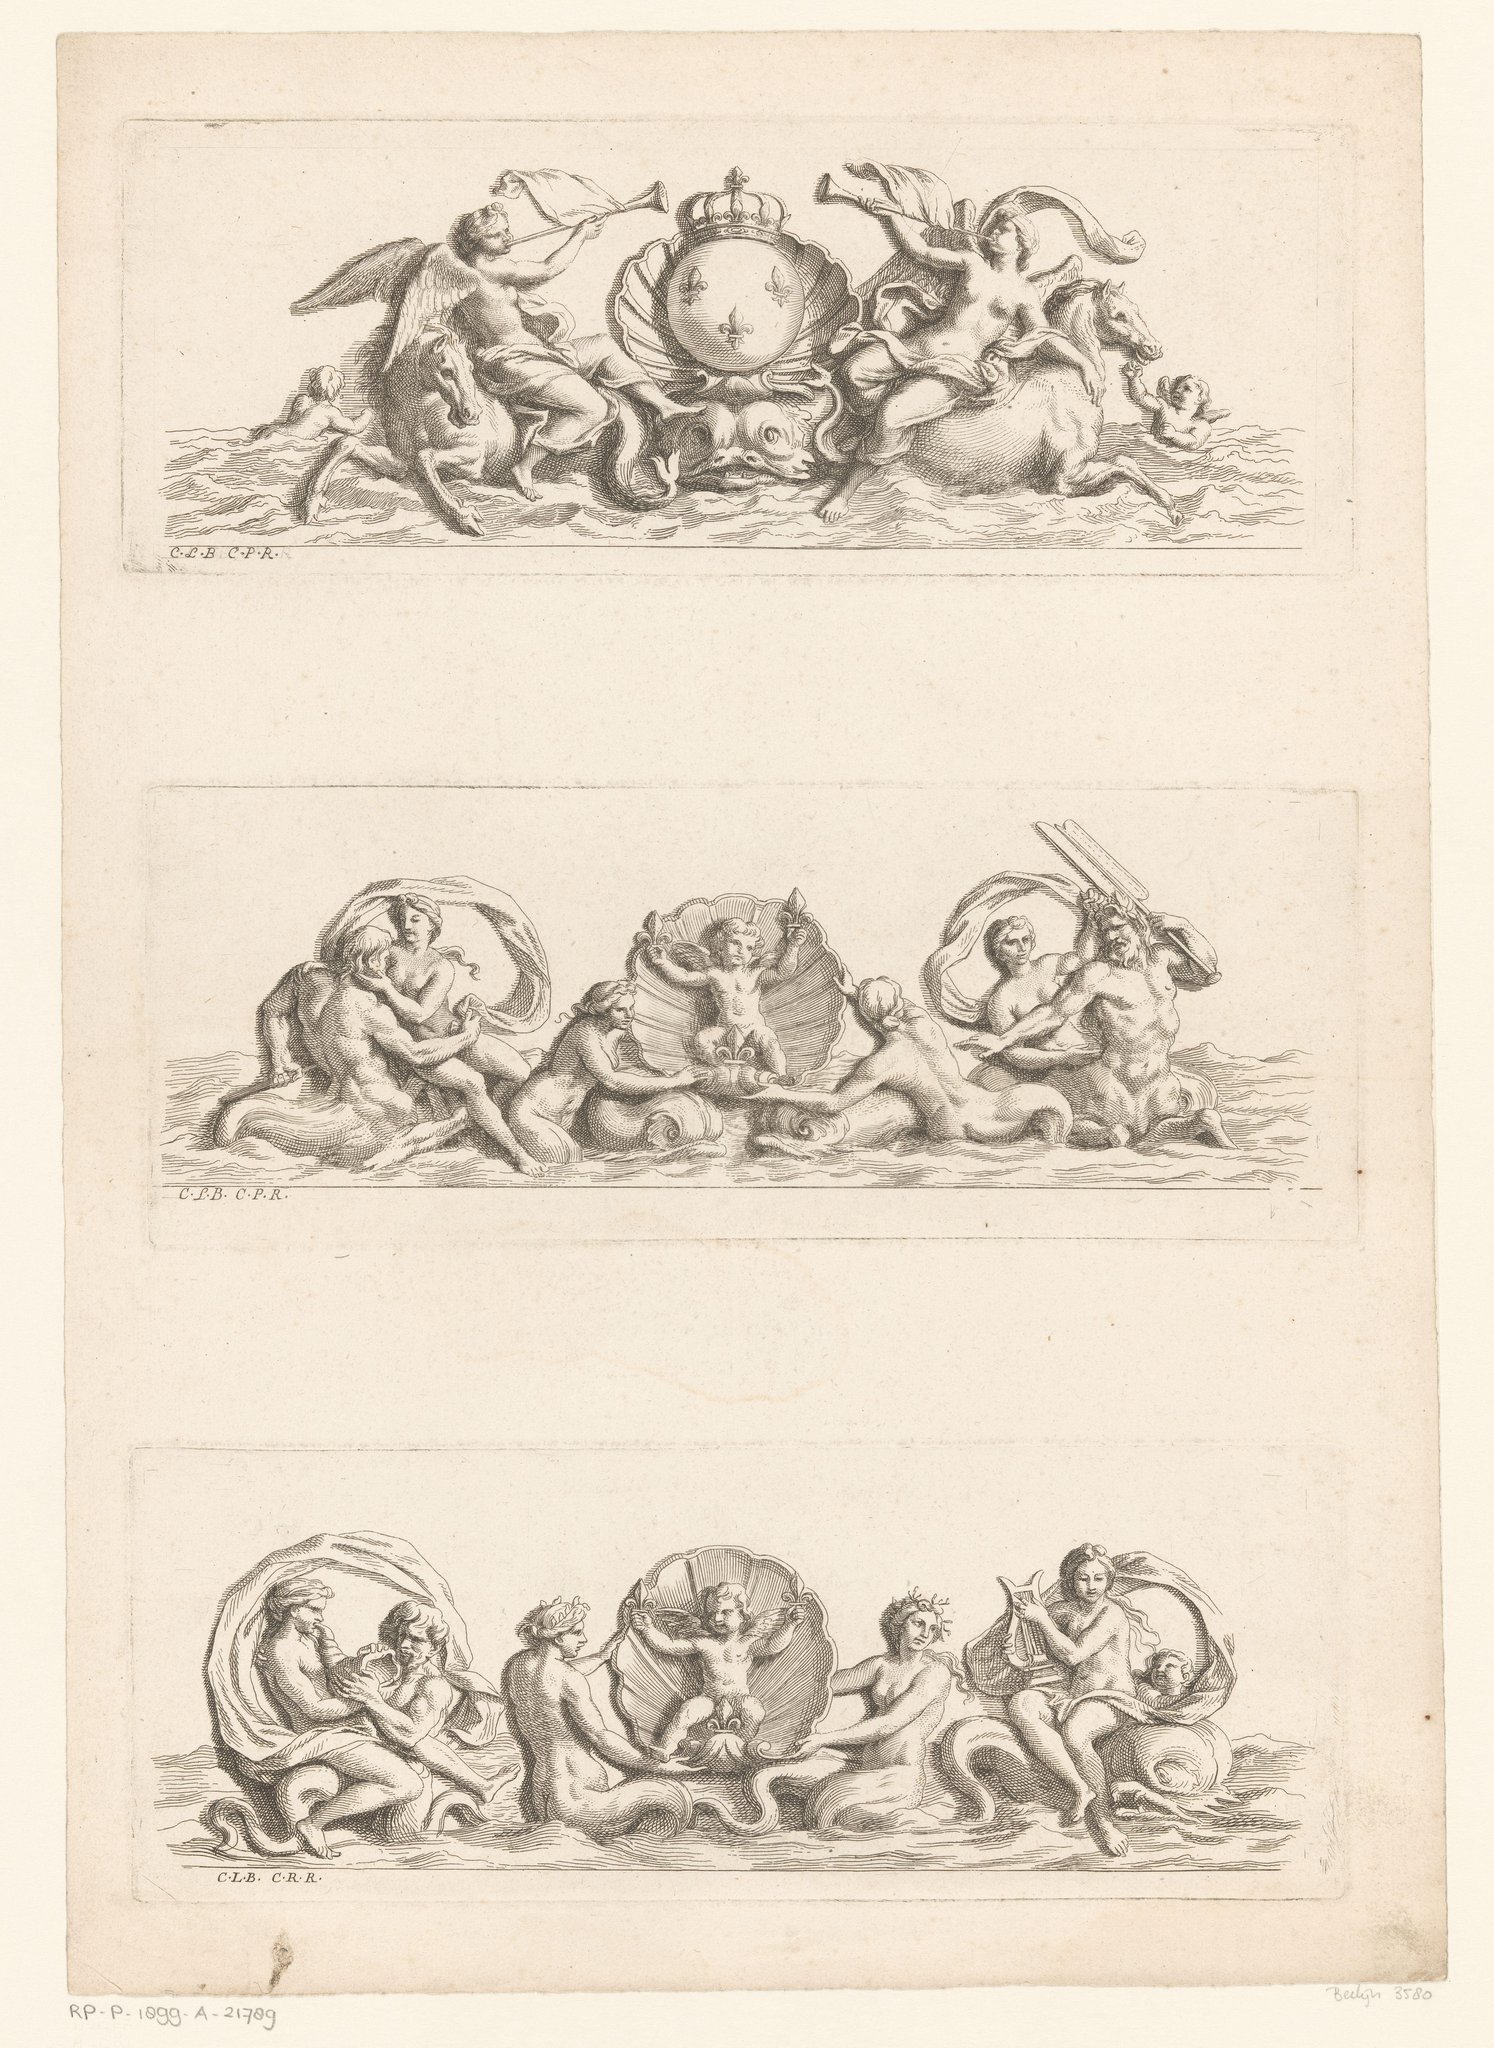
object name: print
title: Friezen met wapen van Frankrijk, putti en zeewezens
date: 1672-1686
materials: paper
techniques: etching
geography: paris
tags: coat of arms (as symbol of the state, etc.), monsters ~ fishes, cupids: 'amores', 'amoretti', 'putti'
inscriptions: collector's mark: Lugt 2228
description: Drie friezen op een blad. Boven: Gekroond wapen van Frankrijk in een schelp op een fontein, geflankeerd door hippocampi en engelen blazend op bazuinen. Midden: Een putto zittend in een schelp met fleur-de-lis, geflankeerd door meerminnen en vrouwen zittend op meermannen. Onder: Een putto zittend in een schelp met fleur-de-lis, geflankeerd door meerminnen en vrouwen met een schelp en een lier zittend op een meerman en een dolfijn.